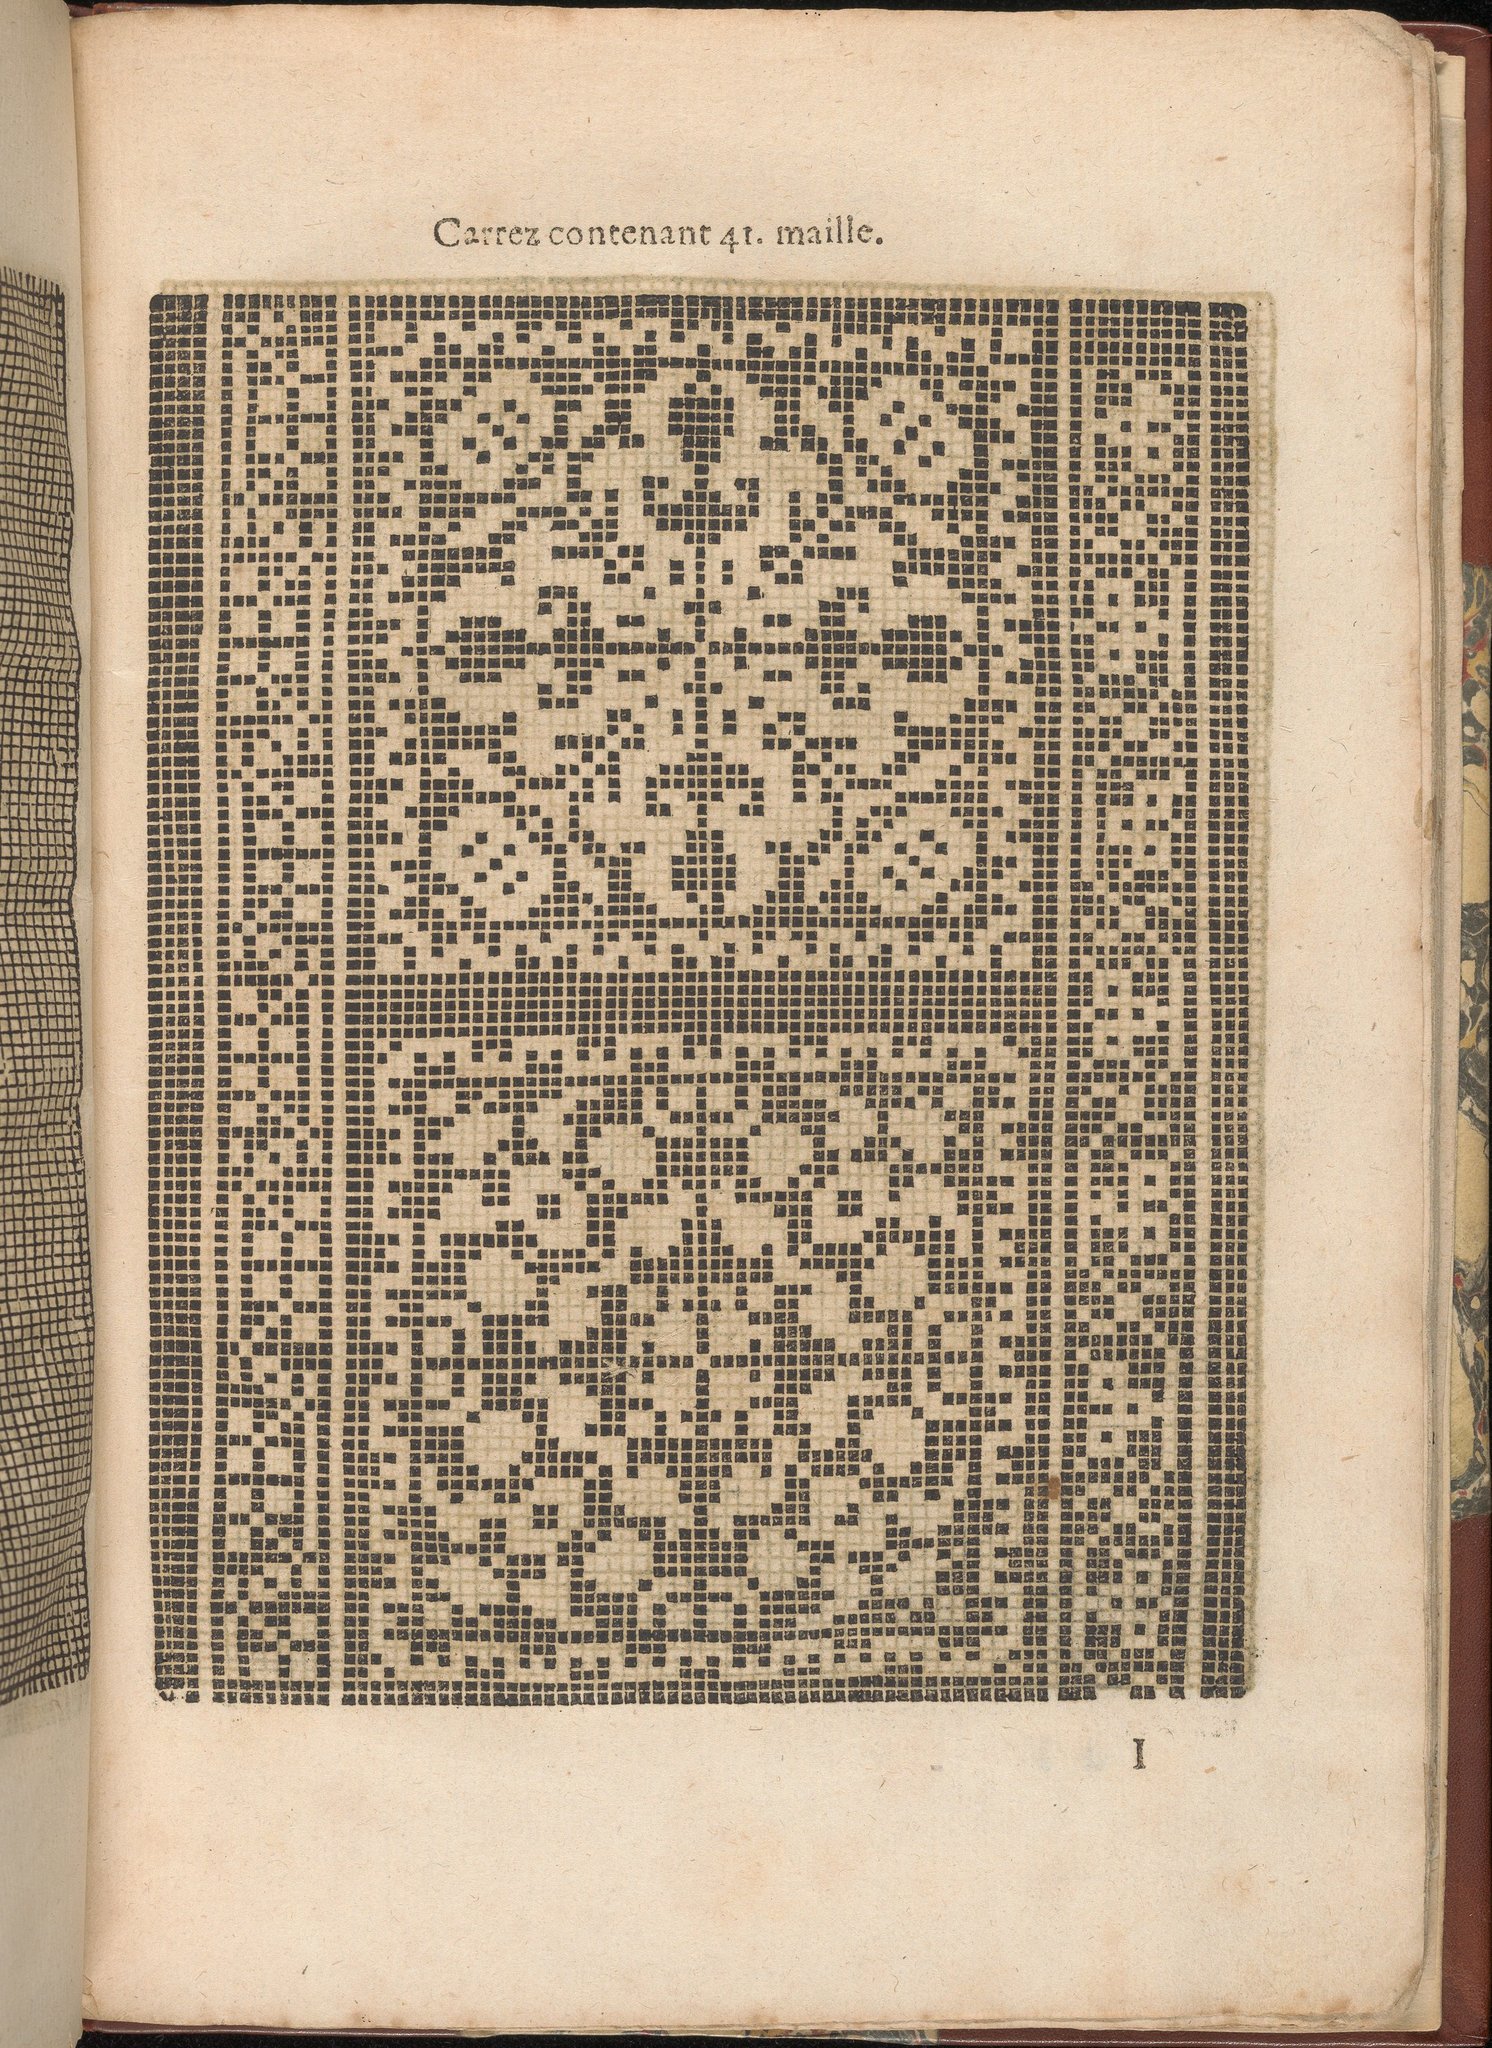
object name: book print ornament architecture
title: Les Secondes Oeuvres, et Subtiles Inventions De Lingerie du Seigneur Federic de Vinciolo Venitien, page 33 (recto)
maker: federico de vinciolo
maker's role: designer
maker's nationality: italian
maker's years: 1582-1599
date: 1603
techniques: woodcut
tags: ornament